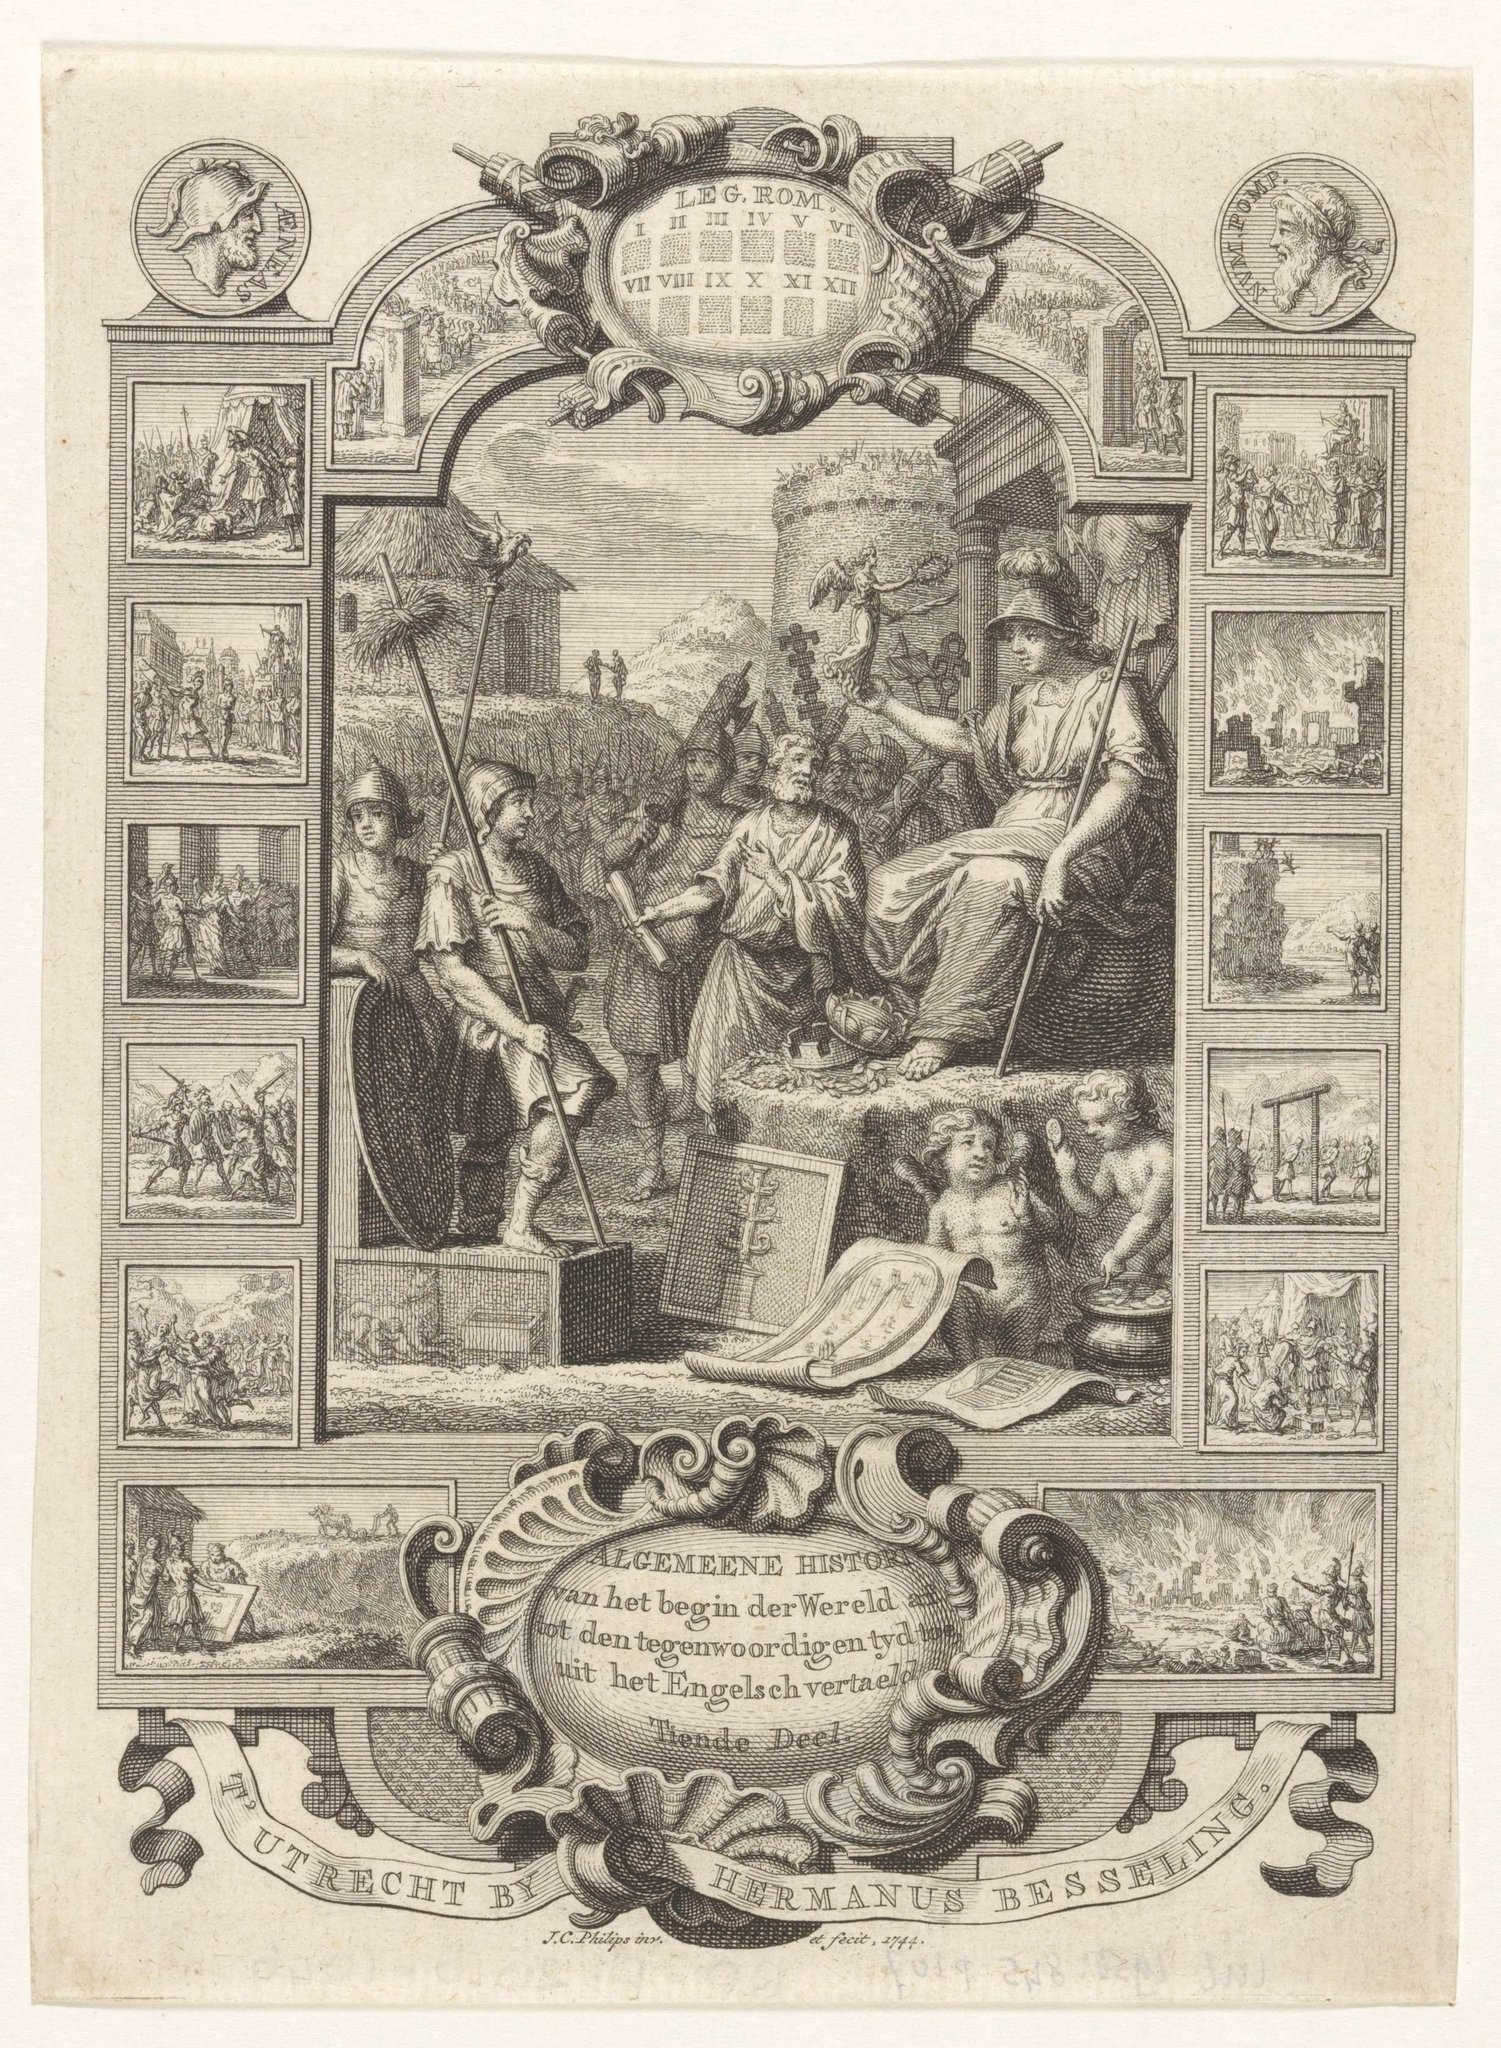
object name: titelblad, titelpagina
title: Titelpagina voor: Kornelis Westerbaen, Algemeene histori, 1744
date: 1744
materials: paper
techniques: engraving, etching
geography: amsterdam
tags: personifications of countries, nations, states, districts, etc., (story of) aeneas, rome (one of the four world empires)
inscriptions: collector's mark: Lugt 2228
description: De personificatie van het Romeinse Rijk zit met een beeld van Victoria in haar hand en kronen bij haar voeten. Voor haar staan personificaties van het vroege en late Romeinse Rijk. Naast haar staan een man met boekrol en een groep soldaten. In de achtergrond verbeelden een woning met rieten dak en een toren en portaal de vroege en late periode van het Rijk. In de omlijsting van de cartouche scènes die te maken met de geschiedenis van het Rijk en portretmedaillons van Aeneas en mogelijk historicus Pompeius Tragus.